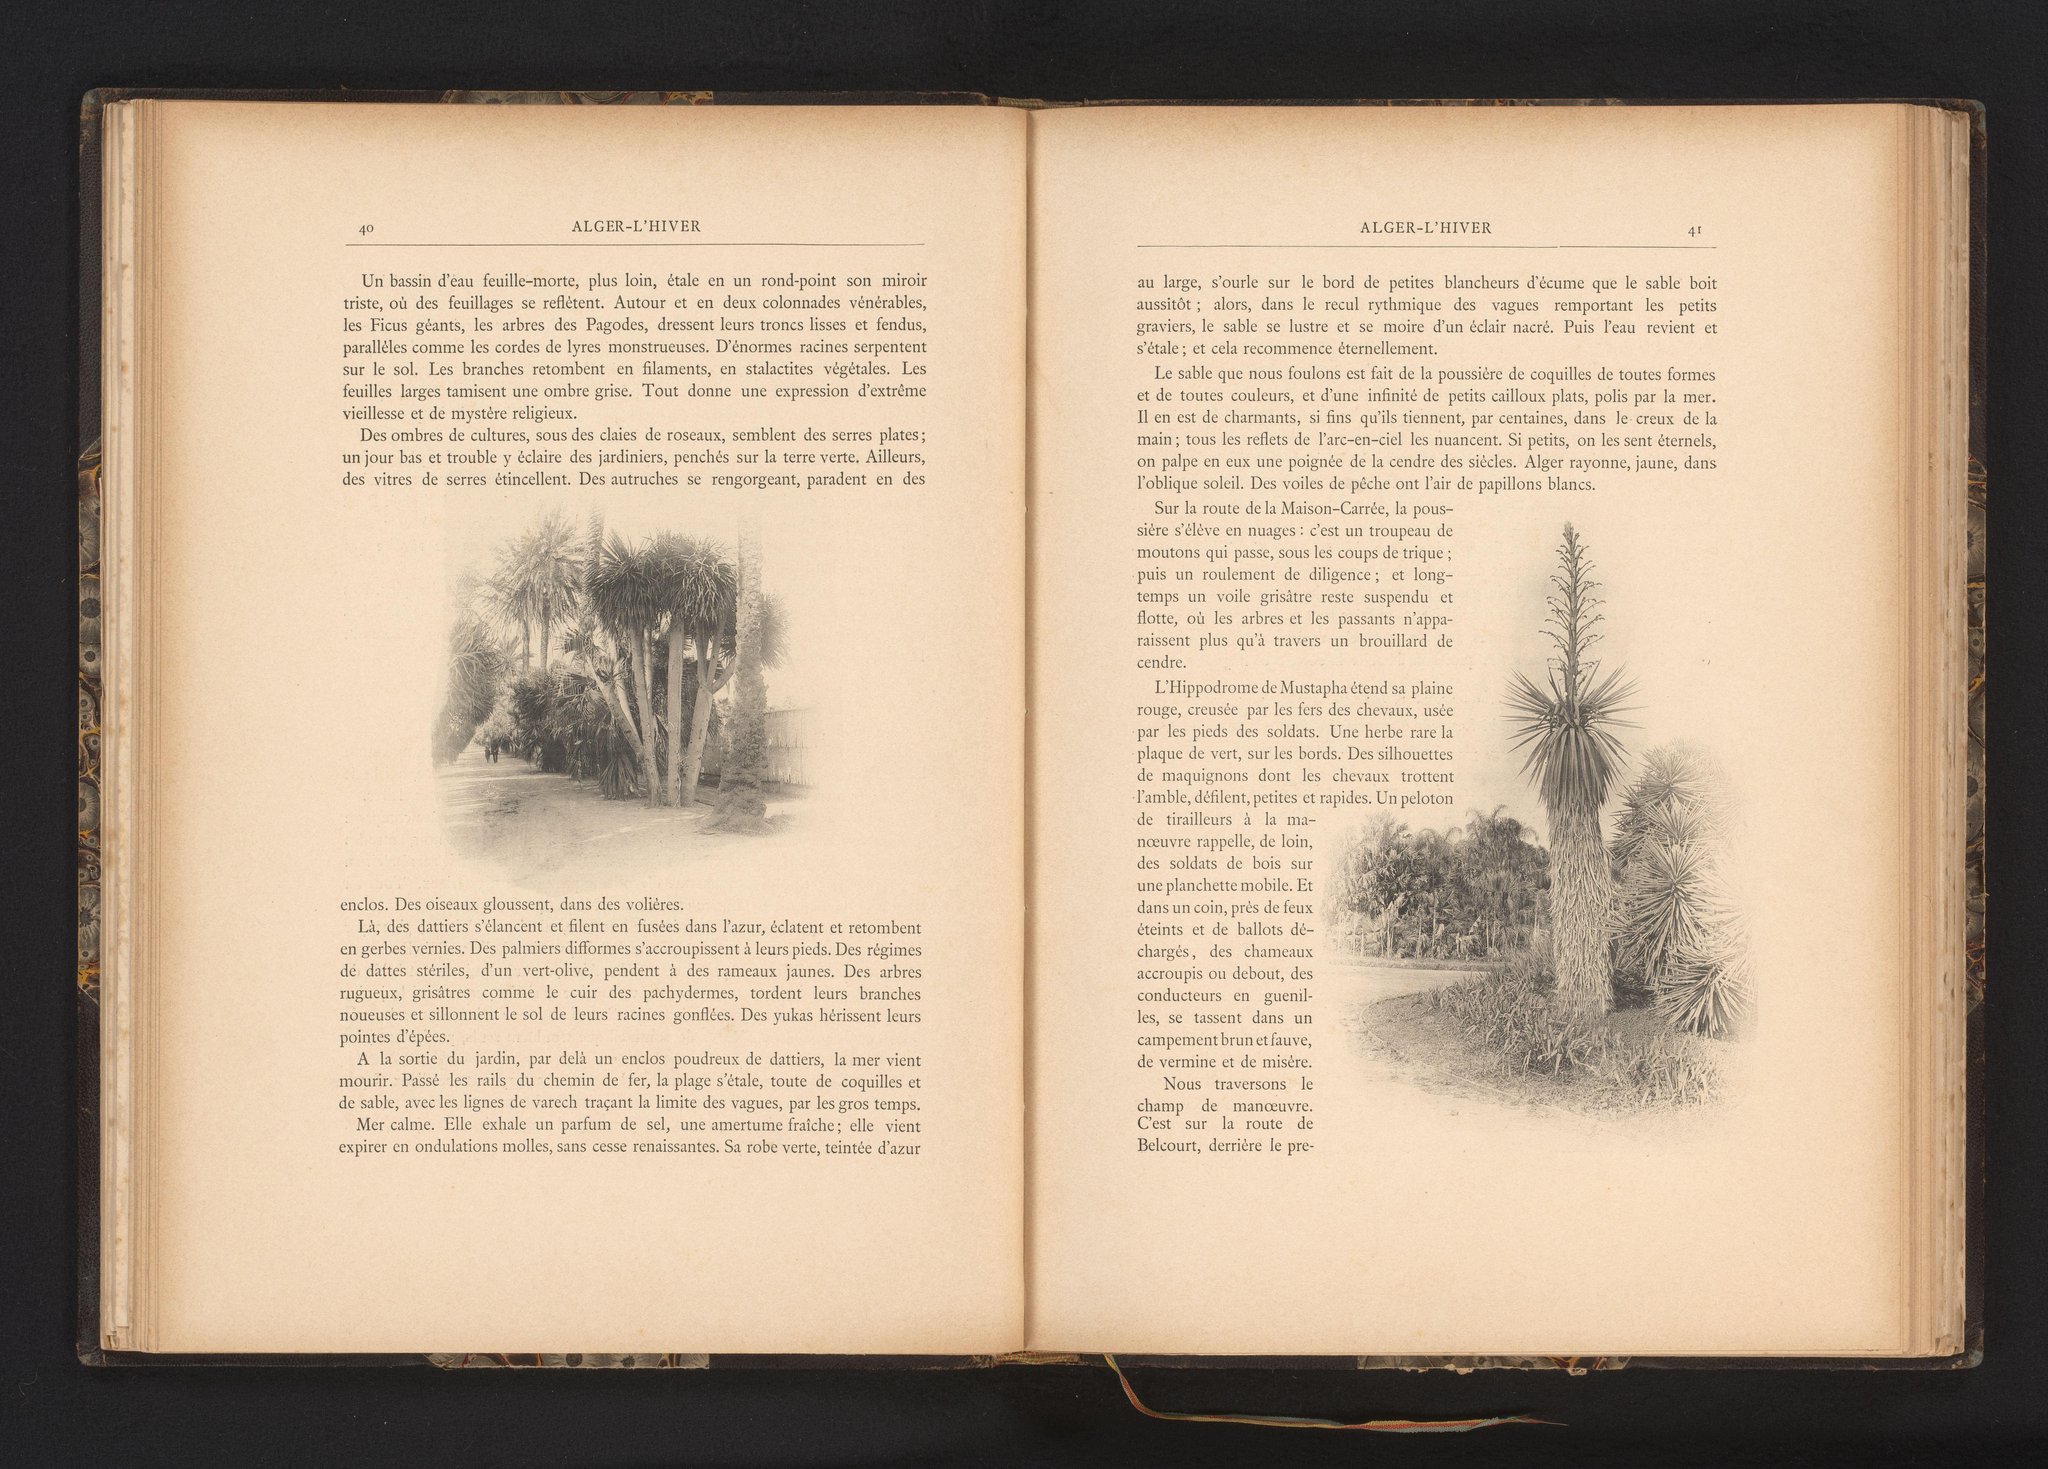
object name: photomechanical print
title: Boom langs een weg in Algiers, Algerije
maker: jules gervais-courtellemont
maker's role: fotograaf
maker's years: 1863-1931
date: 1888-1893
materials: paper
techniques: photograph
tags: trees, street